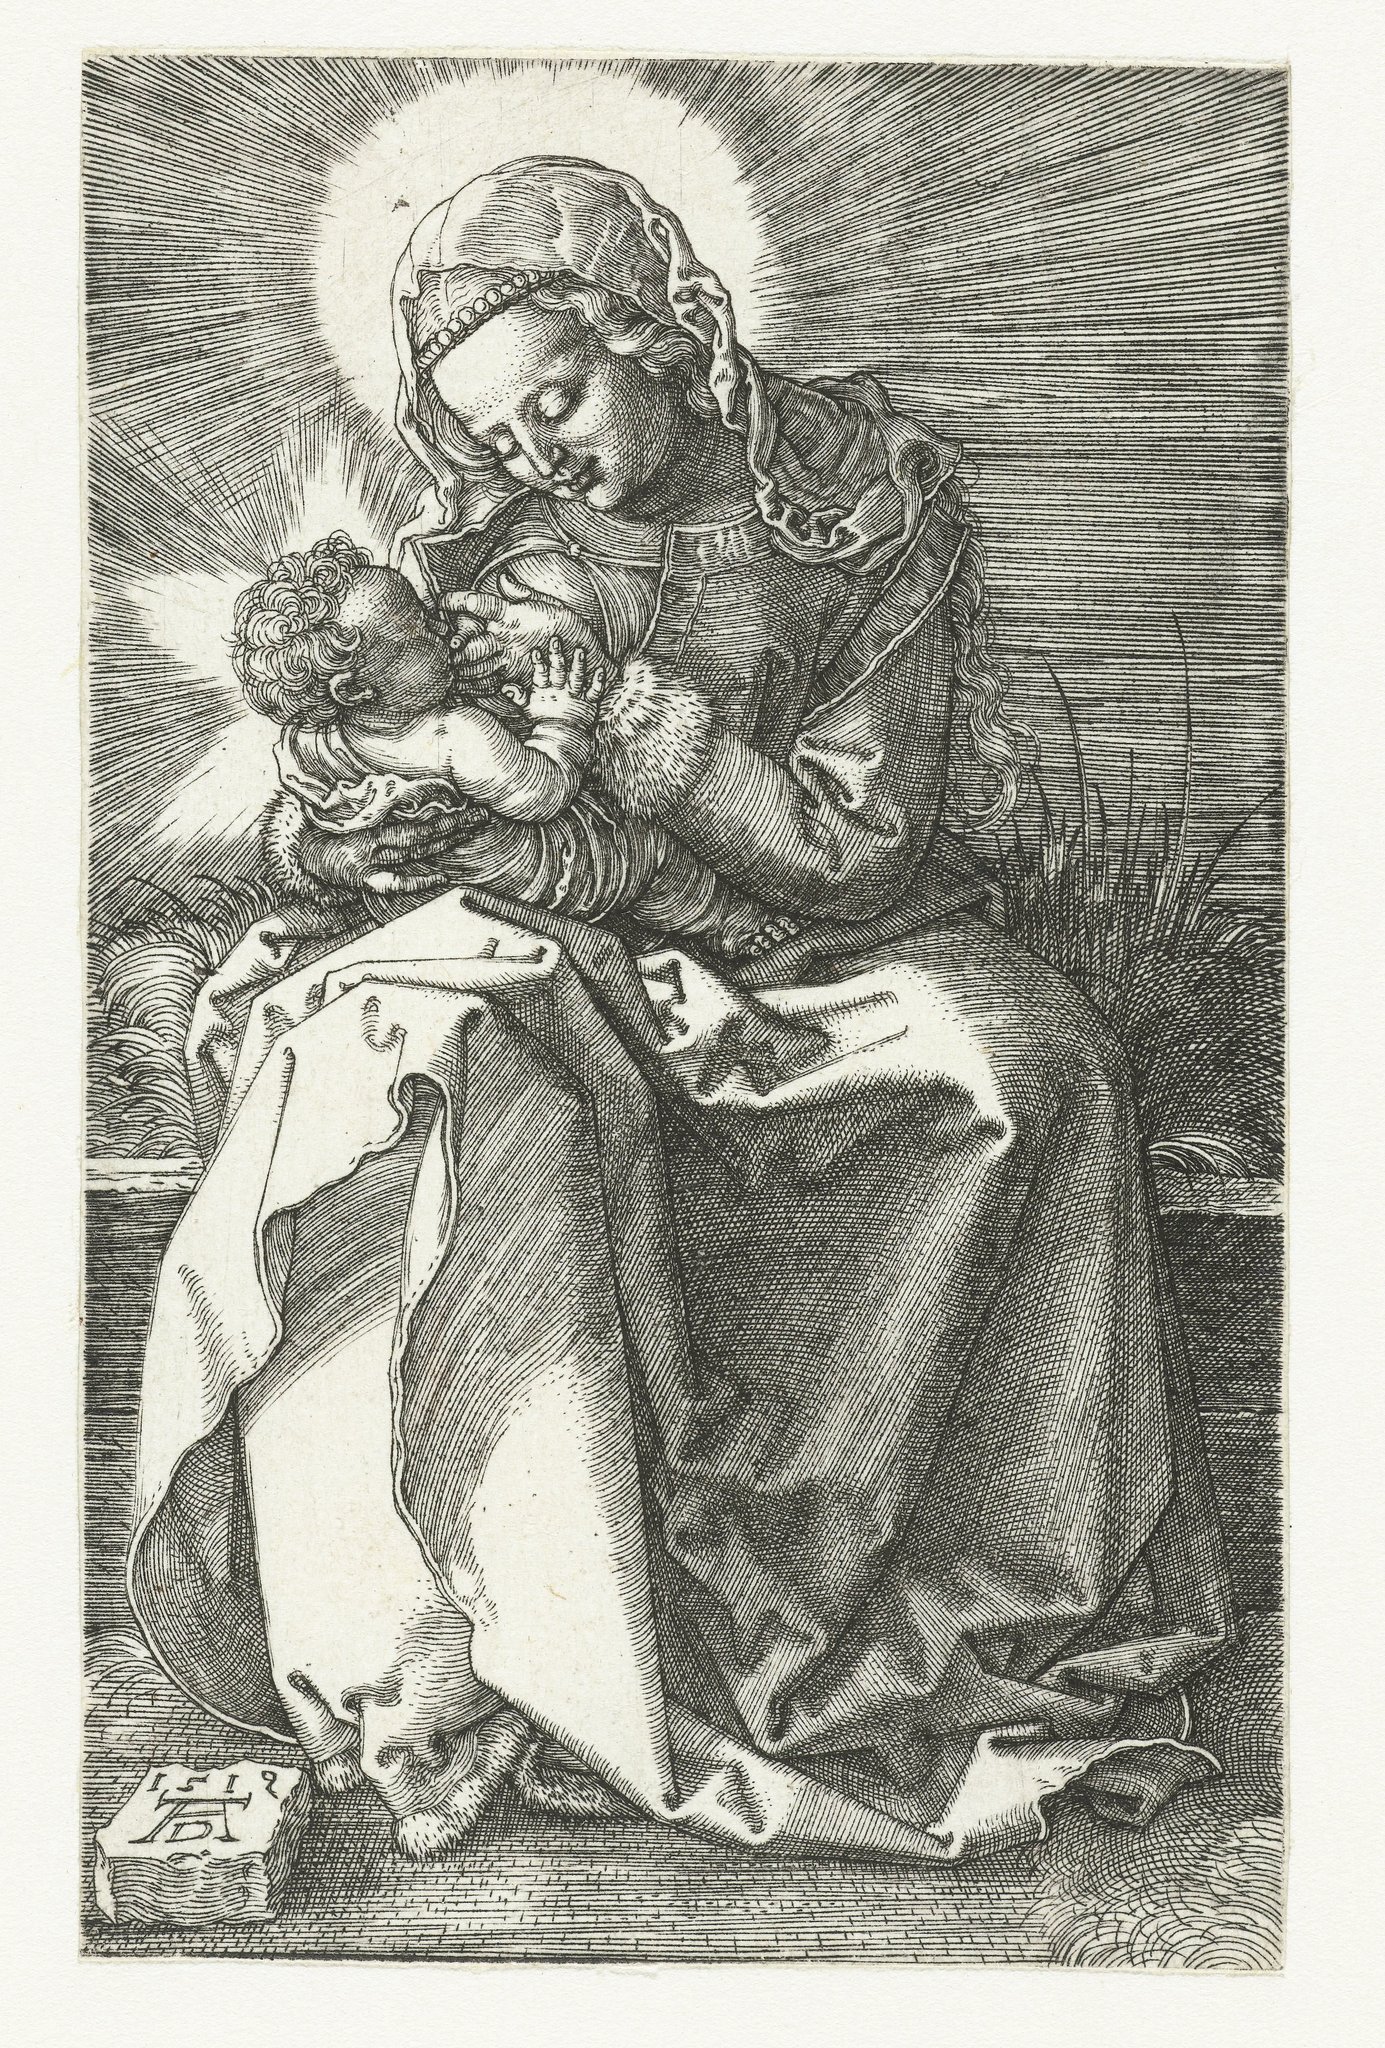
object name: print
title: Maria met kind aan de borst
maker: albrecht dürer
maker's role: draughtsman, painter, print maker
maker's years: 1471-1528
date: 1519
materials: paper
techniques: engraving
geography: nuremberg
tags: christ-child suckling, or beginning to suckle, e.g. mary uncovering her breast ~ madonna-representations, mary sitting or enthroned, the christ-child in front of her in her lap (or in front of her bosom)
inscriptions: collector's mark: Lugt 240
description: Maria zit op een muurtje en zoogt het Christuskind aan de rechterborst.